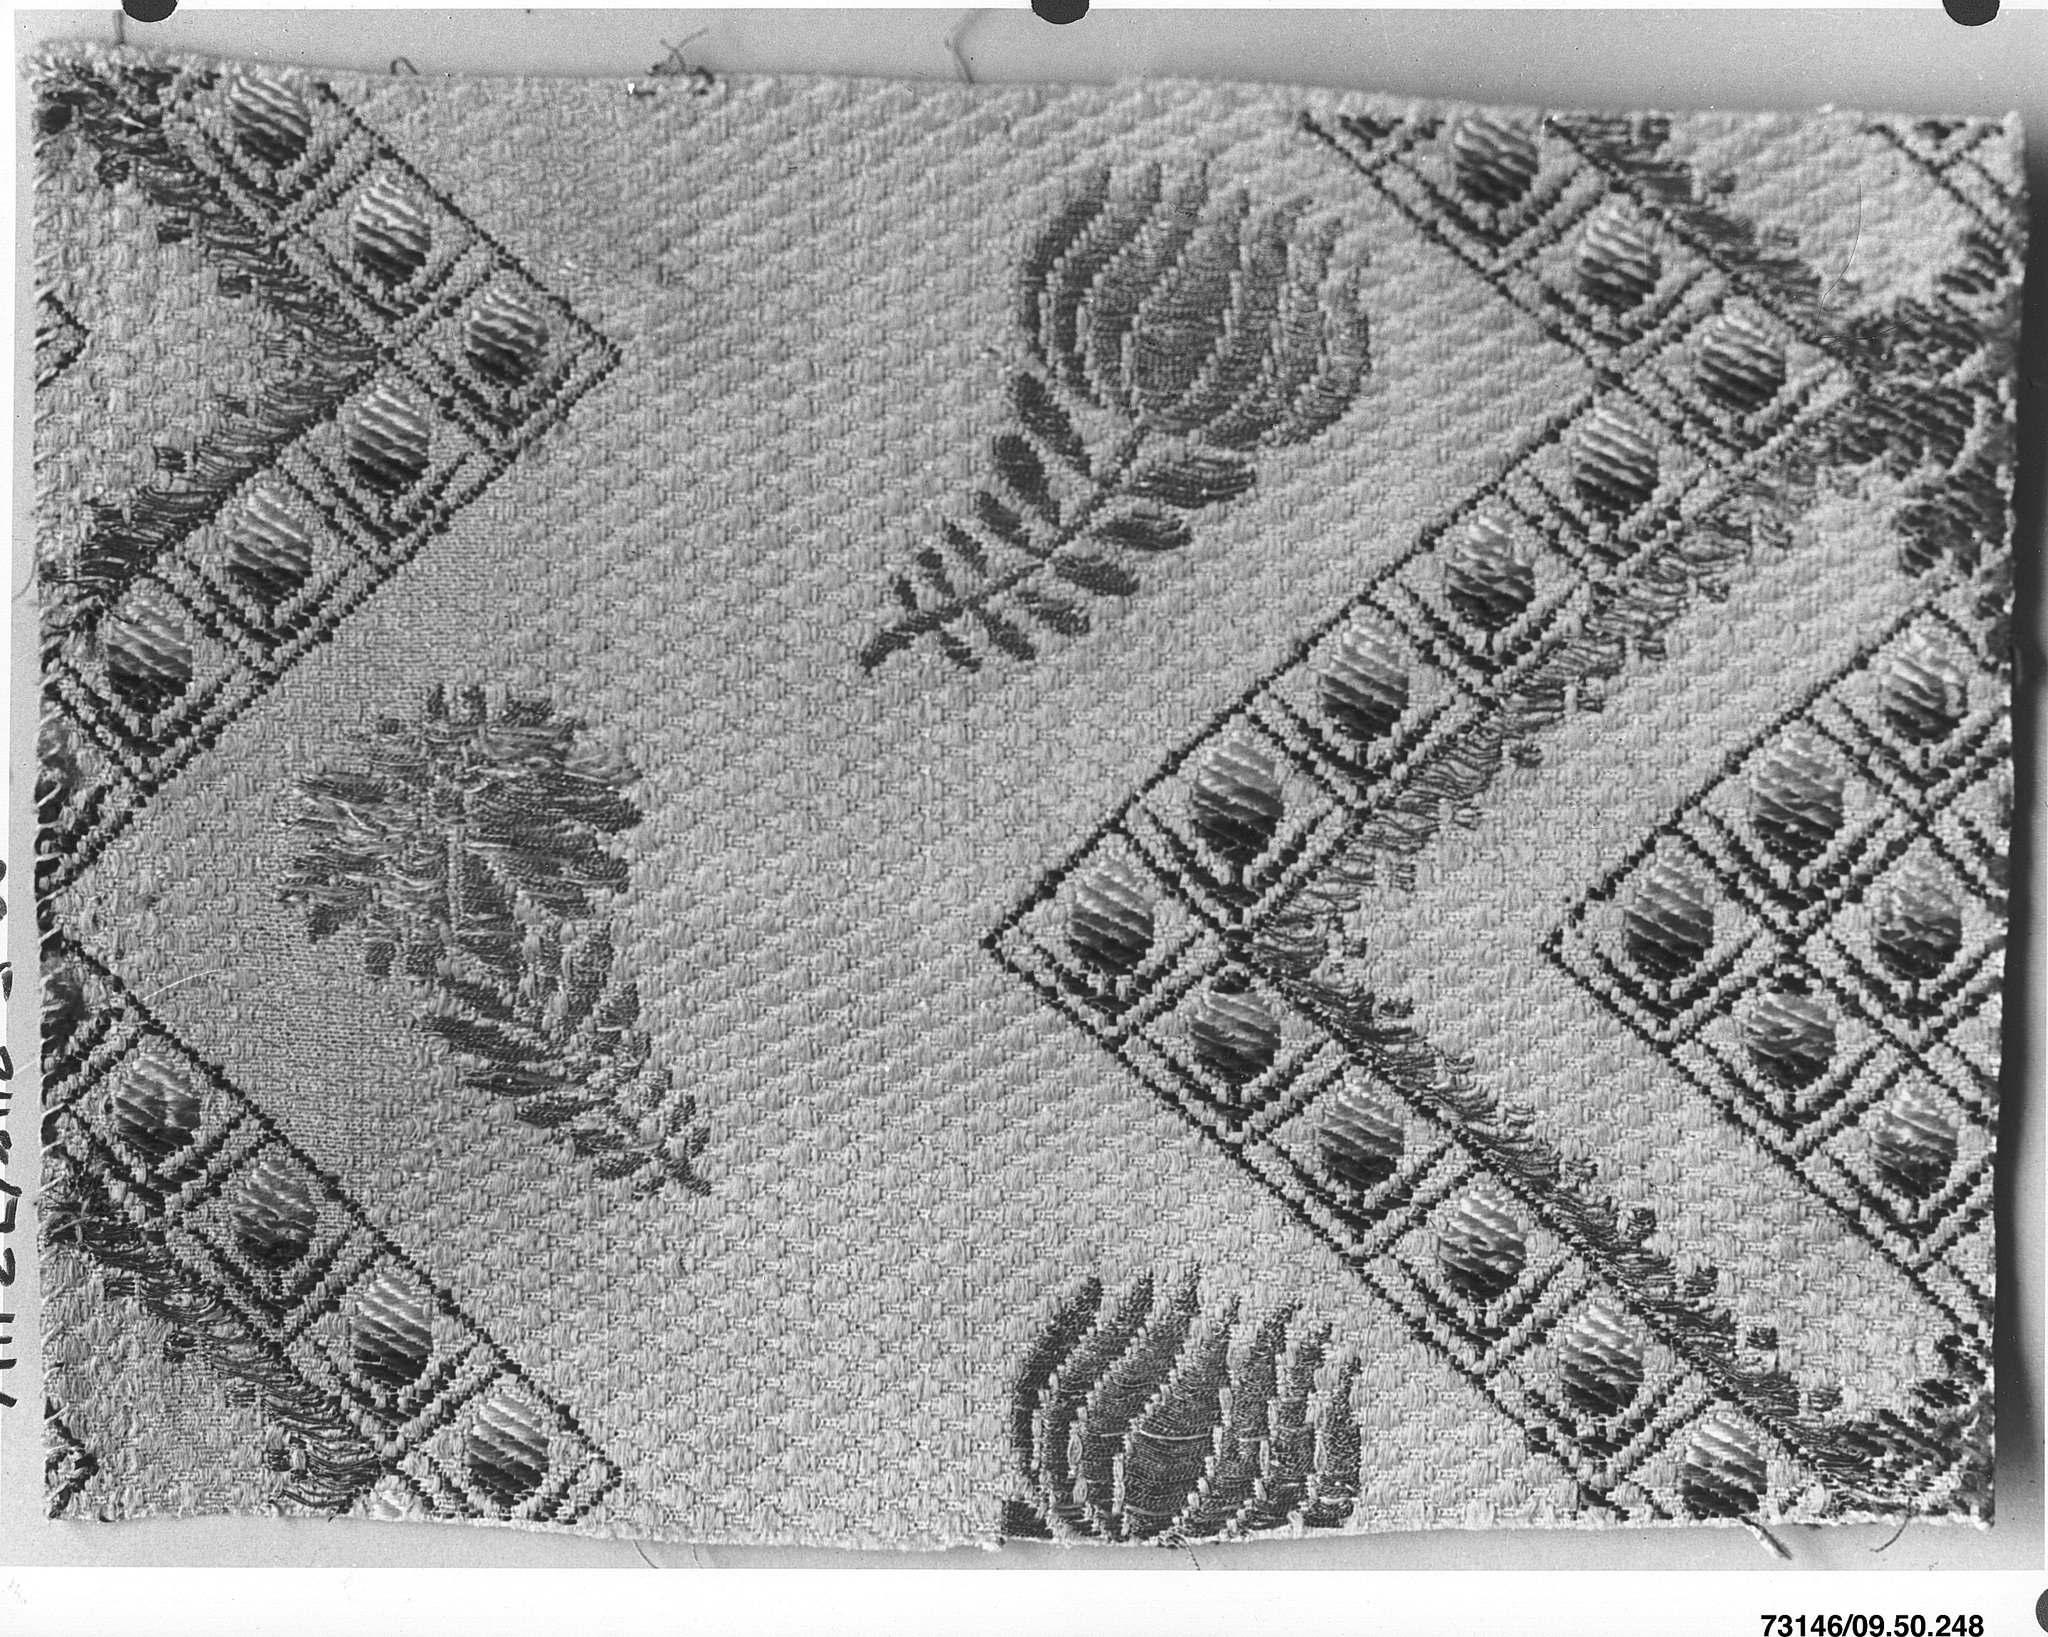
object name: fragment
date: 1801-1900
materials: metal thread